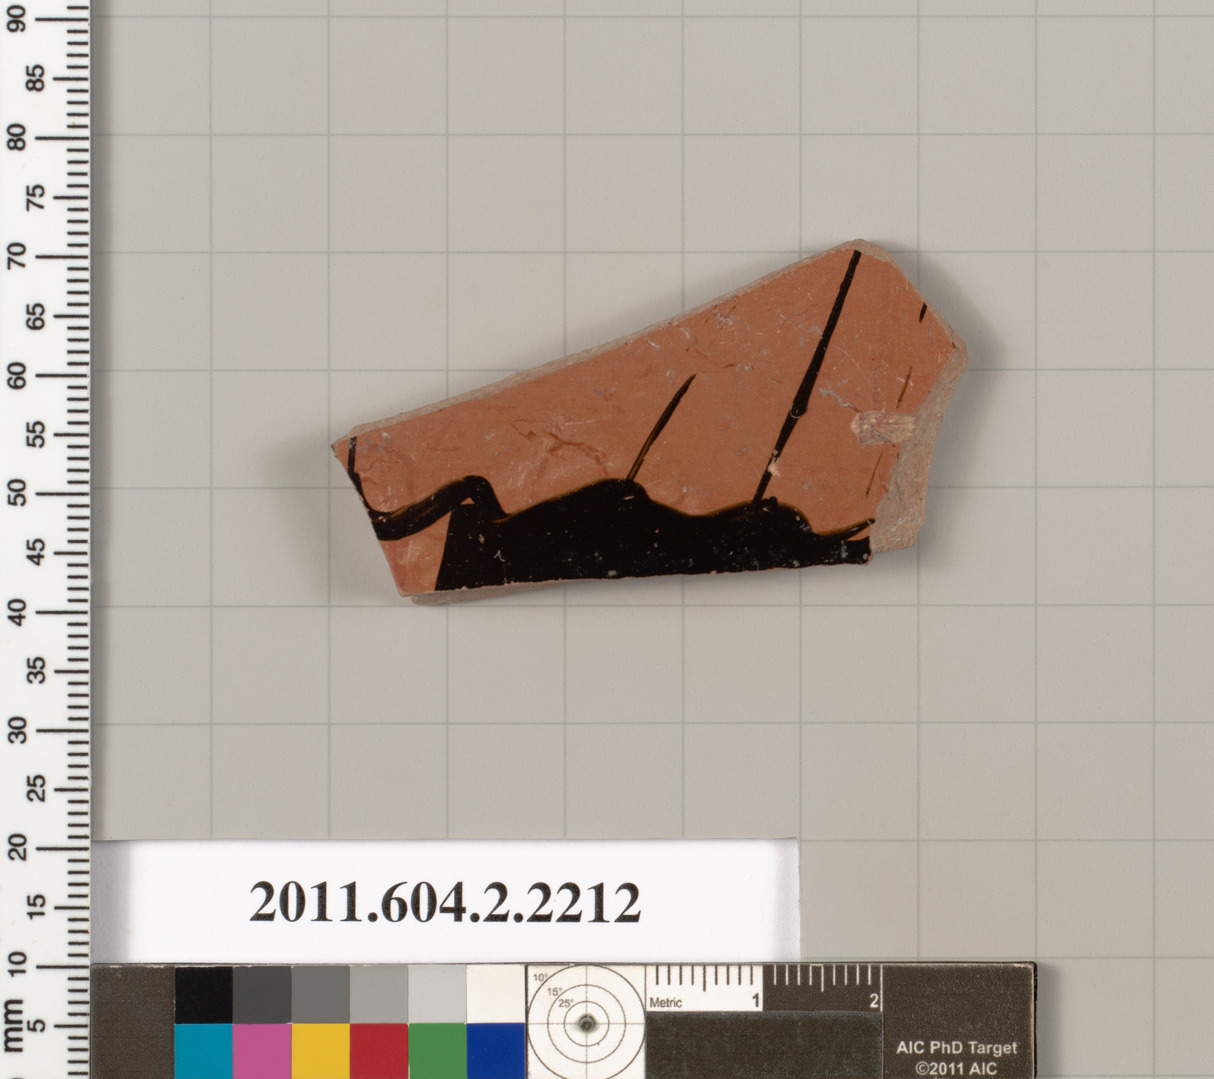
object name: pot fragment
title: Terracotta fragment of a pot; unglazed on the inside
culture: greek, attic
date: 334-301 BCE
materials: terracotta